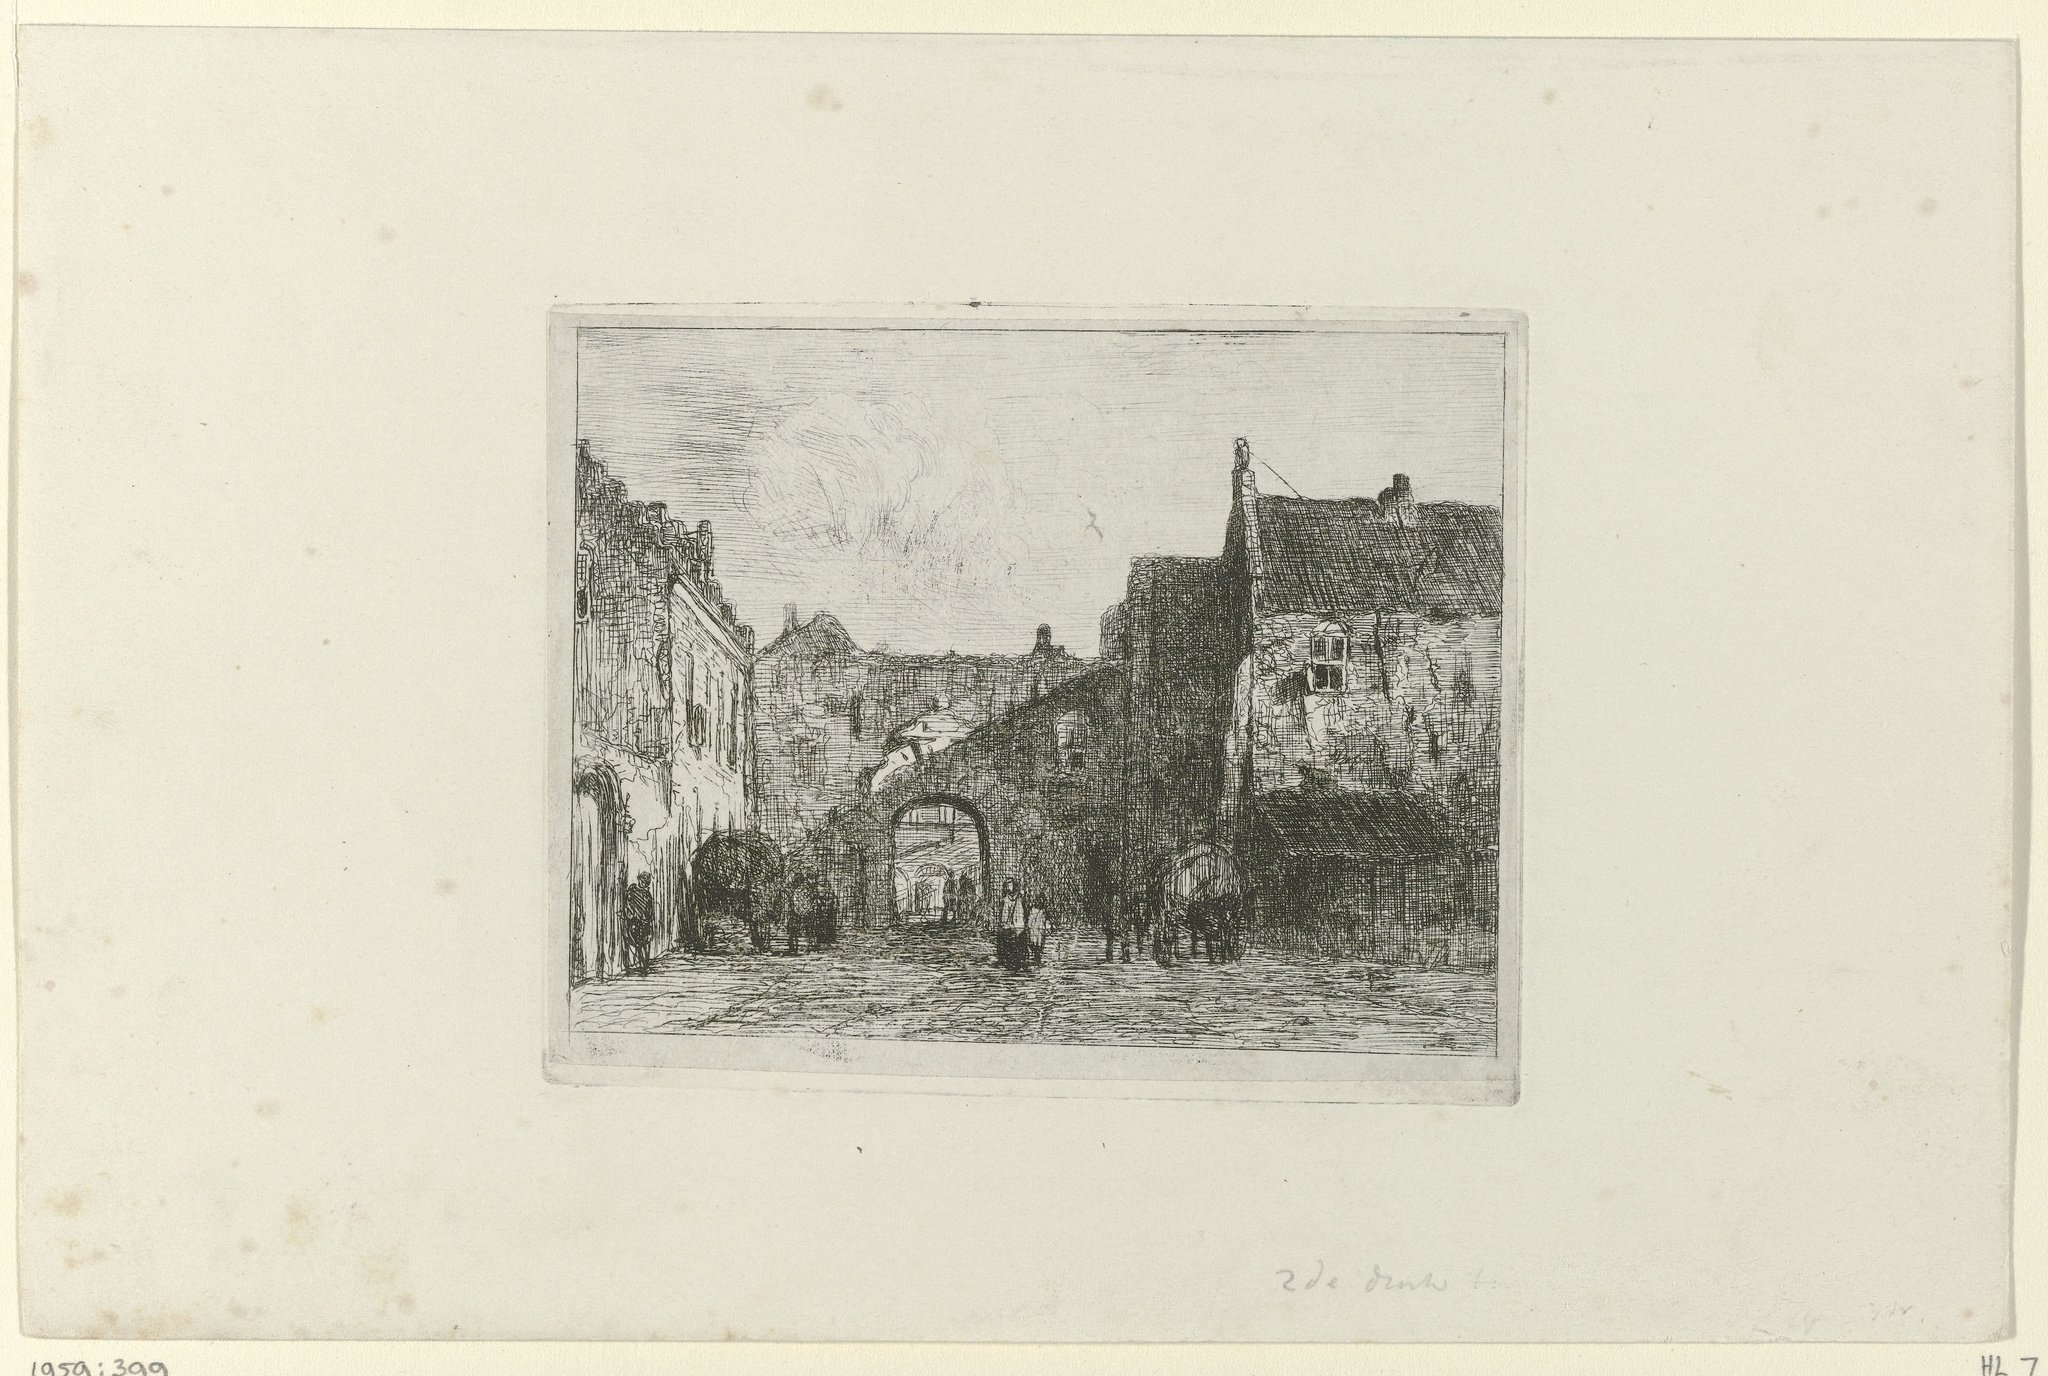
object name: print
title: Gezicht op het Binnenhof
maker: jan weissenbruch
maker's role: painter, print maker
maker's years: 1822-1880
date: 1849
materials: paper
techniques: etching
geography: the hague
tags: city-view, and landscape with man-made constructions, gate, entrance, horse, passenger carriage, civic architecture; edifices; dwellings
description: Op het Binnenhof te Den Haag staan enkele figuren bij twee koetsen met paarden. In de verte ligt de Mauritspoort gezien door de Middenpoort met rechts een gedeelte van de Ridderzaal.